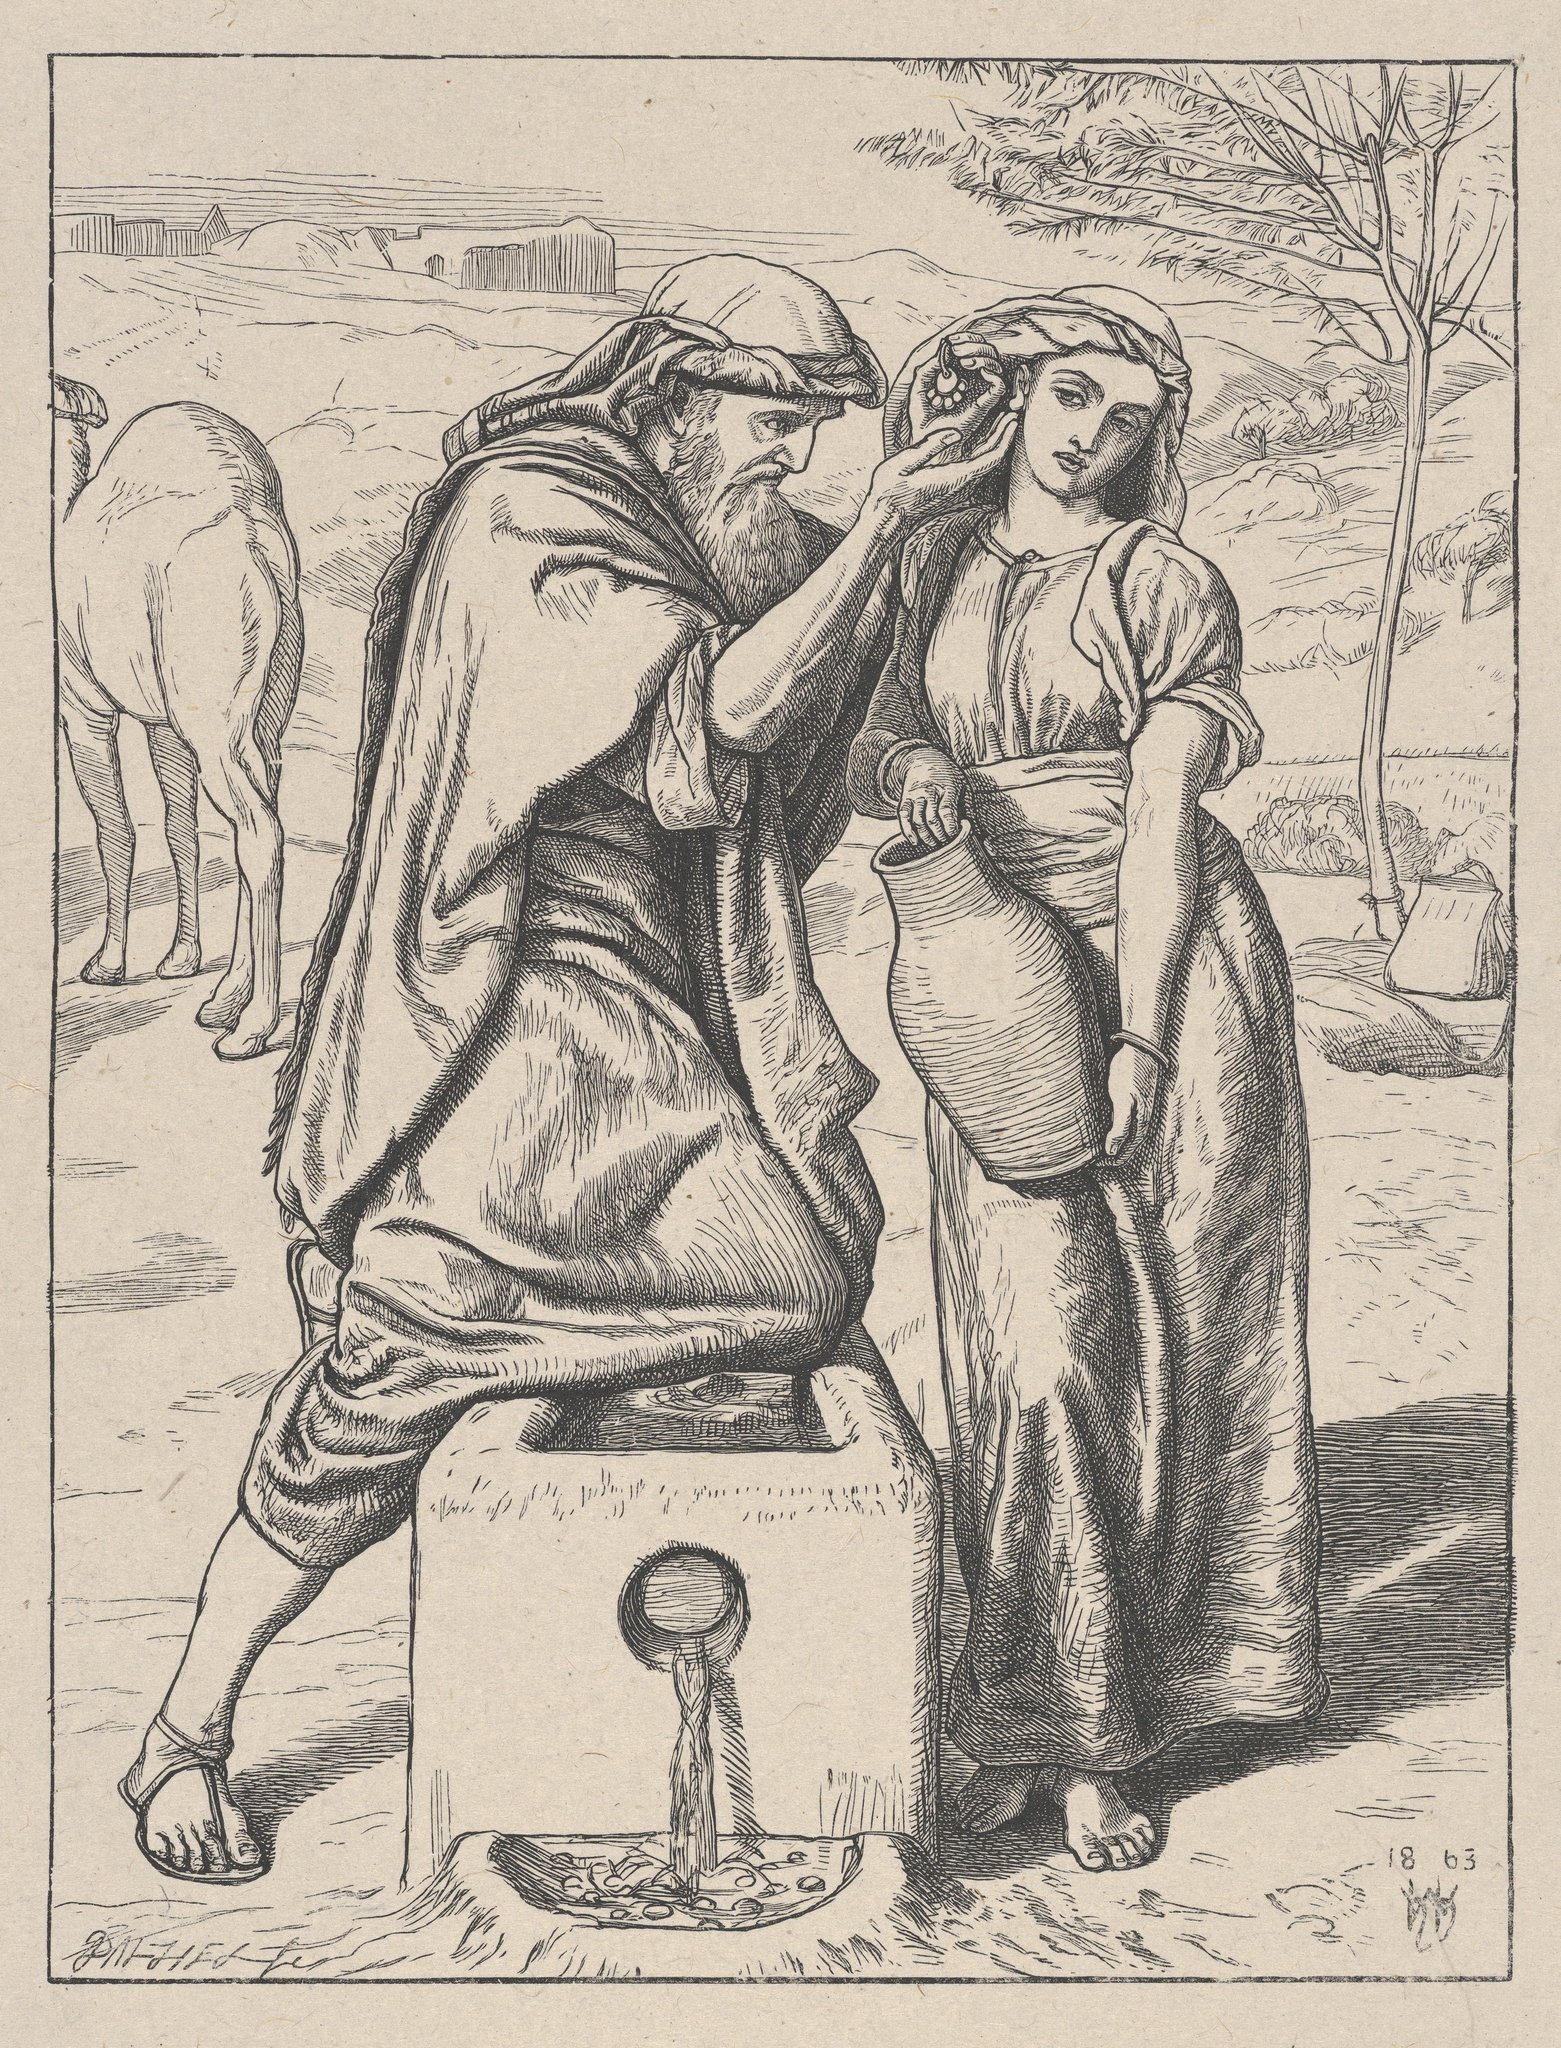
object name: print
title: Eliezer and Rebekah at the Well, from "Dalziels' Bible Gallery"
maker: william holman hunt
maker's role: artist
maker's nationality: british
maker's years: 1827-1910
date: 1863-1881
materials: paper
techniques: engraving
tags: wells,men,women